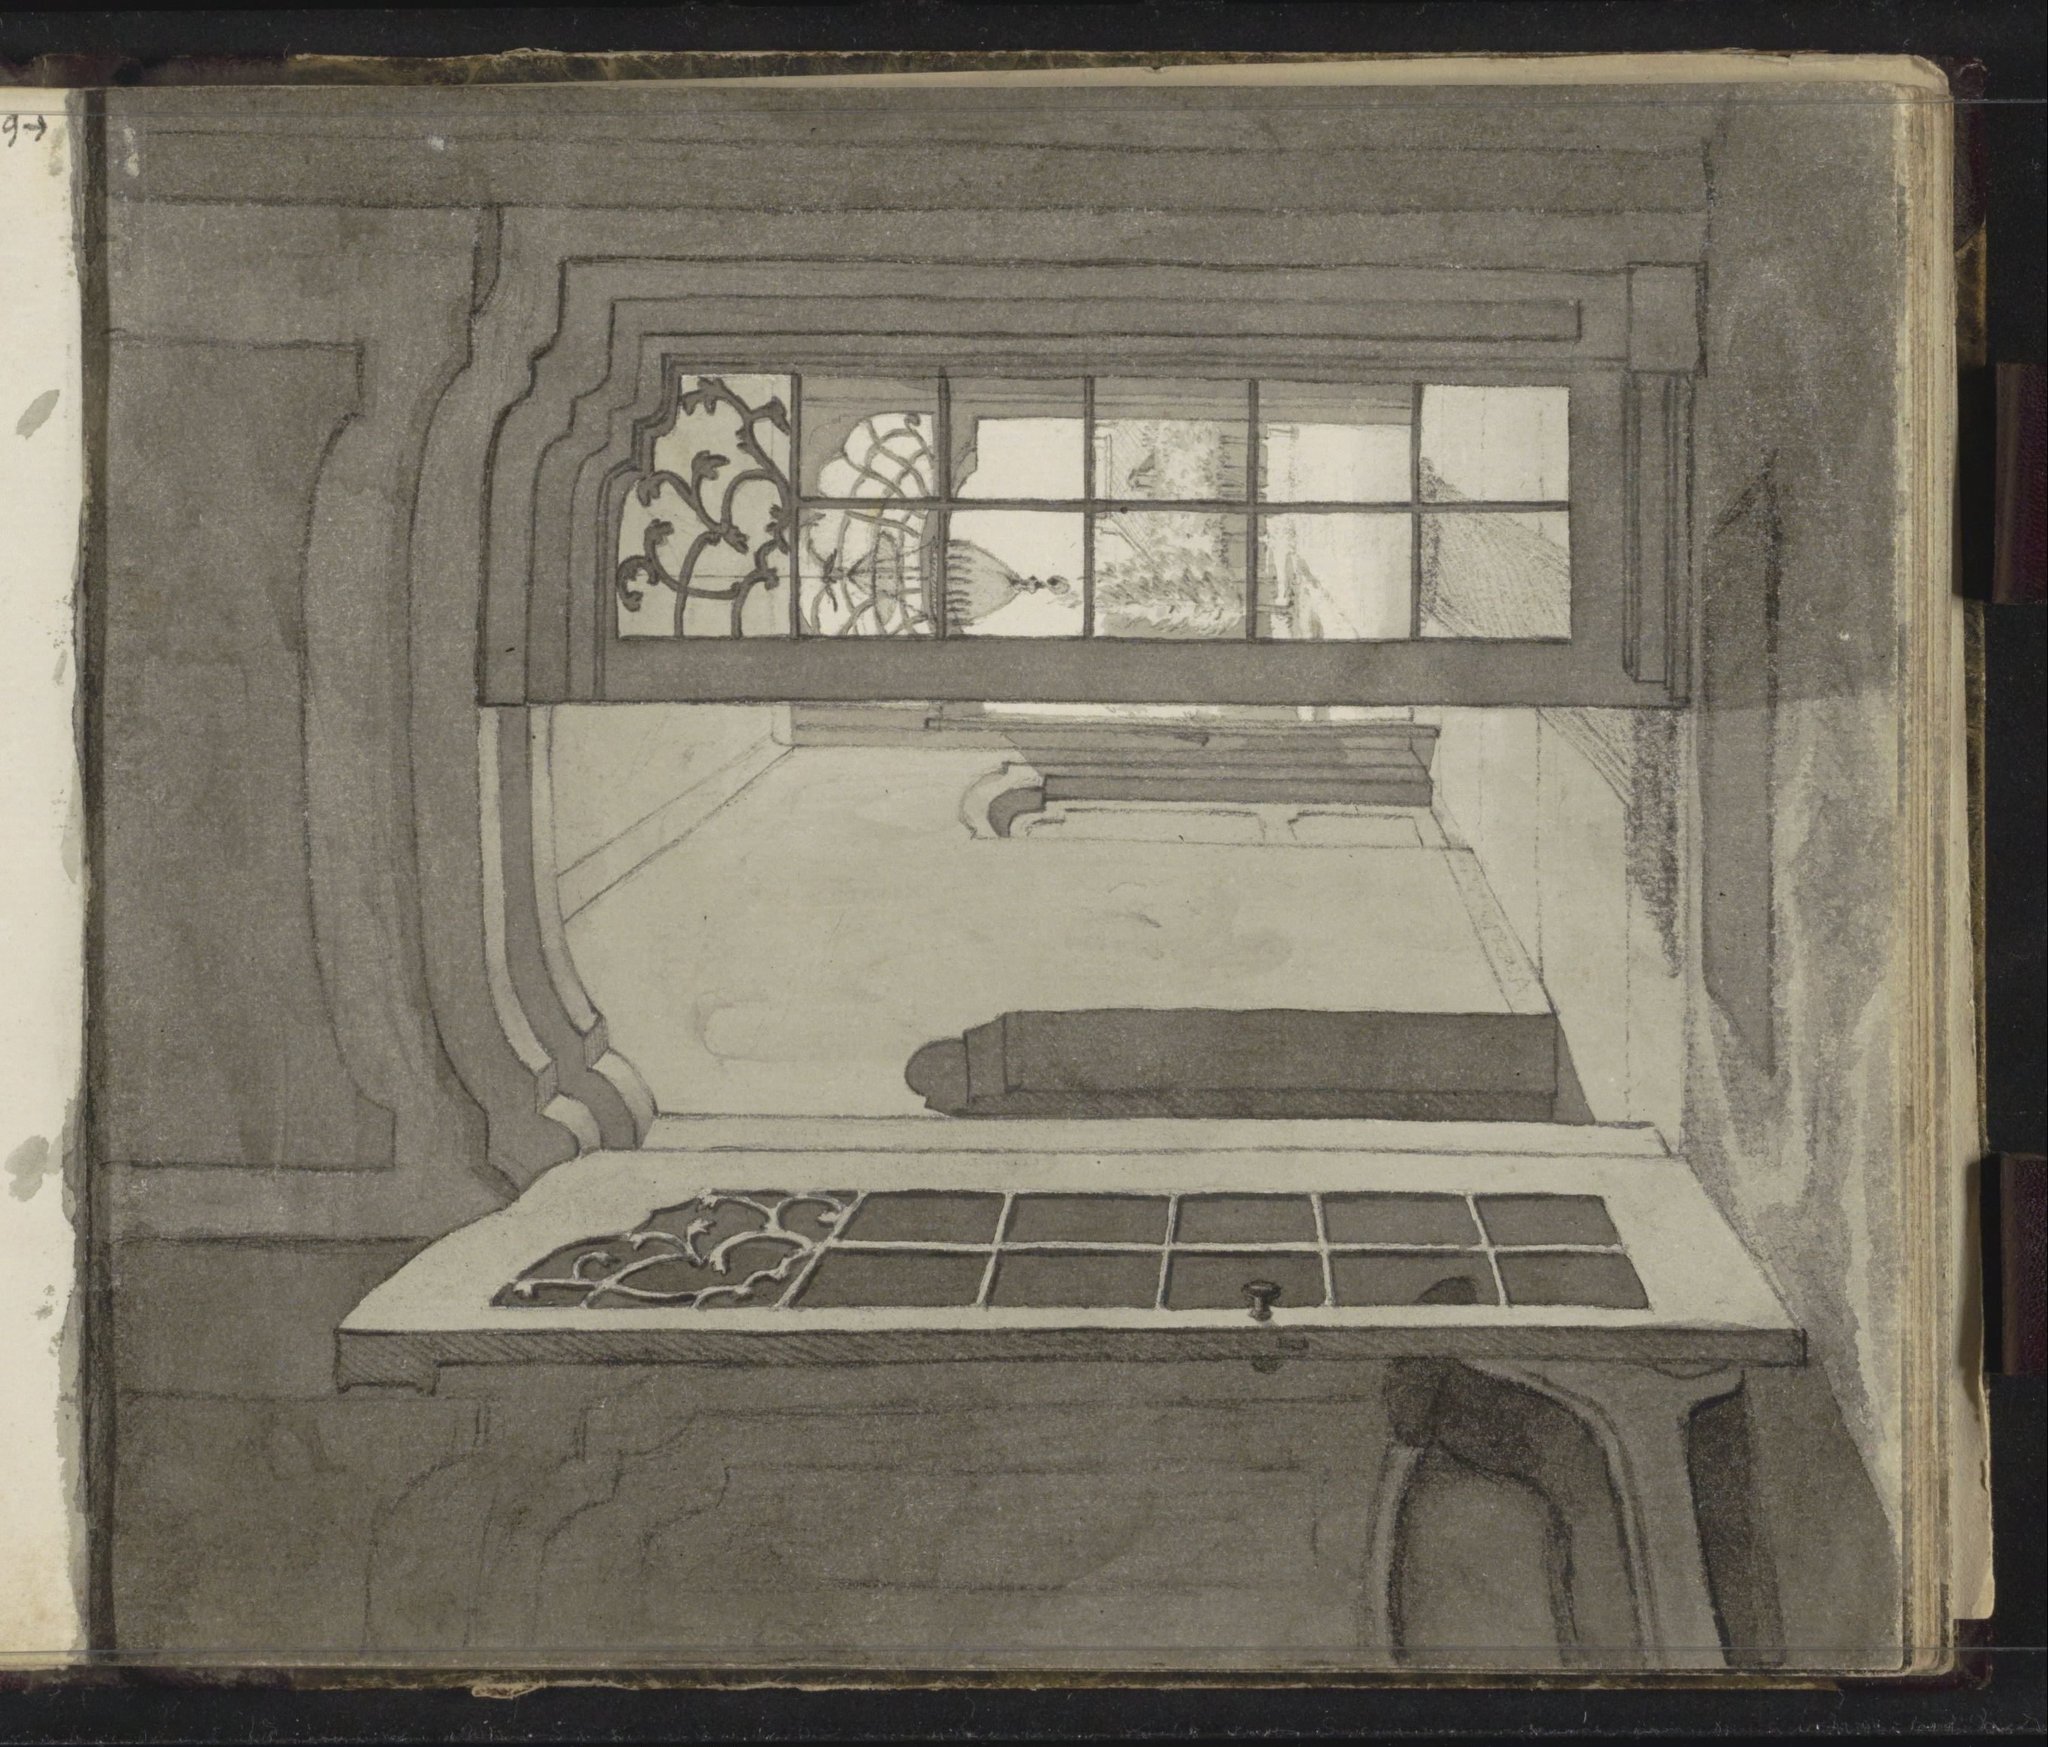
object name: sketchbook leaf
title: Gezicht door de openslaande deuren van een landhuis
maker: hendrik abraham klinkhamer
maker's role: draughtsman, painter, print maker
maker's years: 1810-1872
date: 1820-1872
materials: chalk, paper, watercolor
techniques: brush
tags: open door, country-house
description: Blad 9 recto uit een schetsboek met 39 bladen.